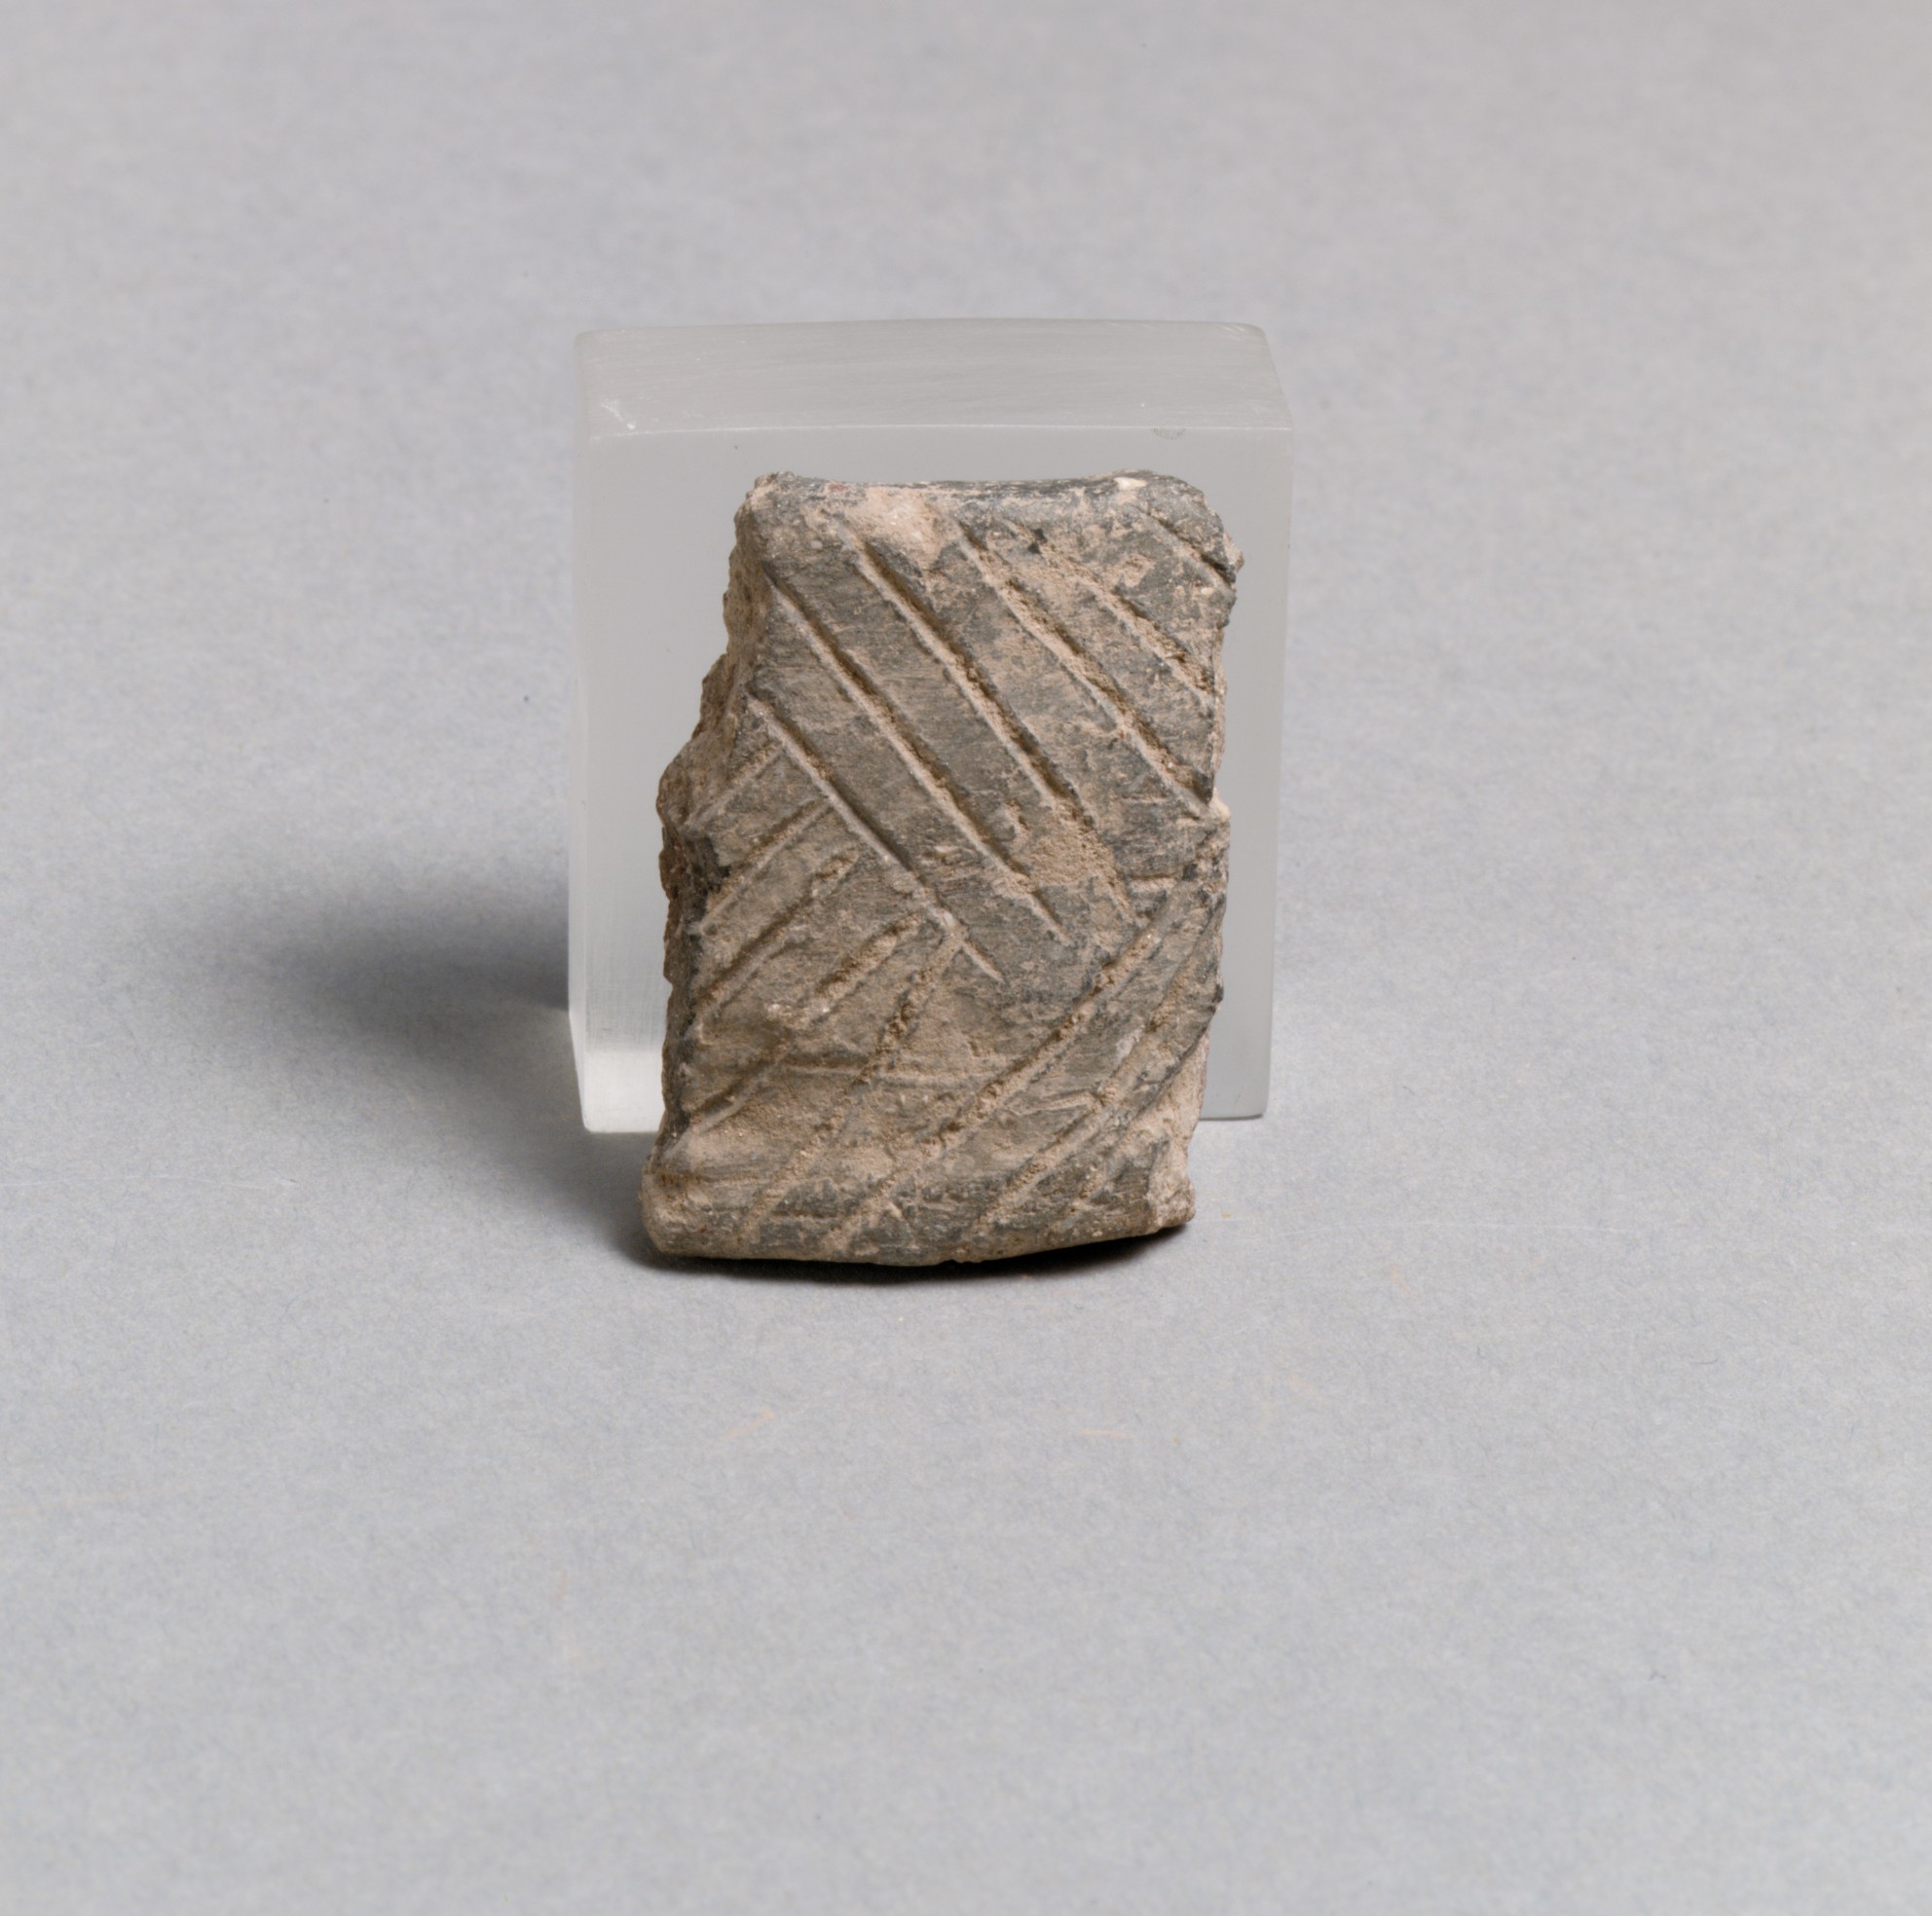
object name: vase fragment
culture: aegean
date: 3000-2000 BCE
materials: terracotta